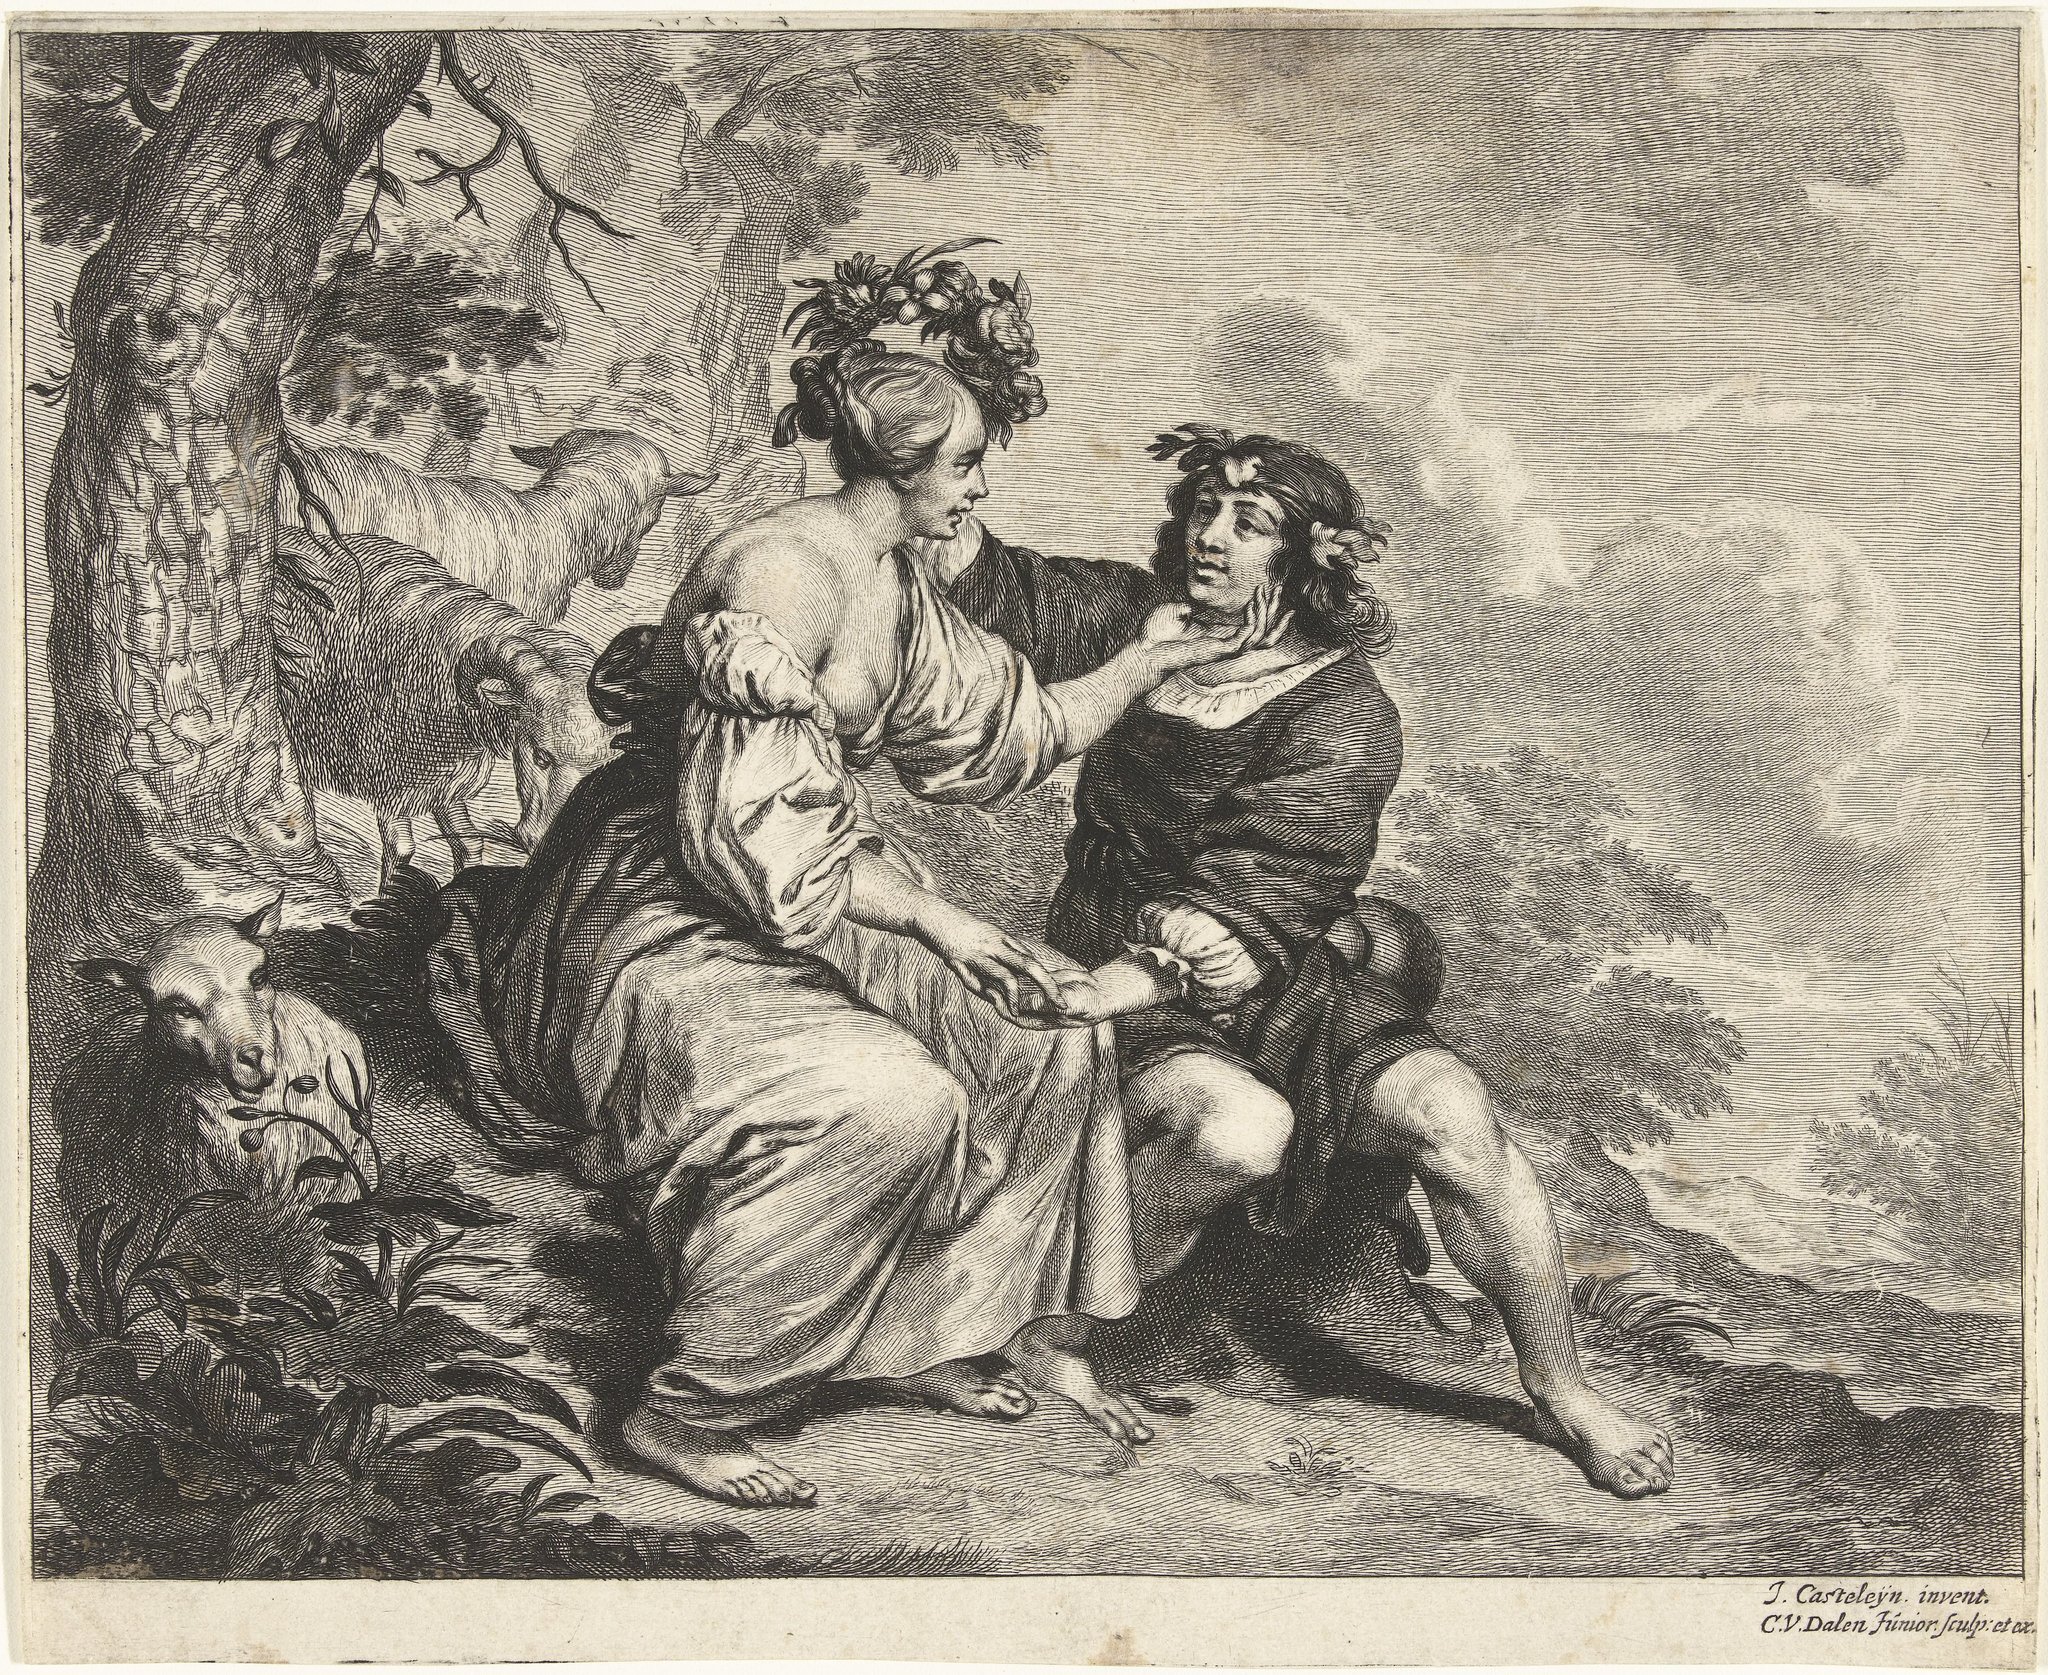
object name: print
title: Herder en herderin in landschap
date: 1648-1664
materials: paper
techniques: engraving, etching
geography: amsterdam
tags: herding, herdsman, herdswoman, shepherd, shepherdess, cowherd, etc., pastorals, arcadian scenes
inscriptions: collector's mark: Lugt 240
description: Prent naar tekening van Casper Casteleyn in de collectie van het RMA.